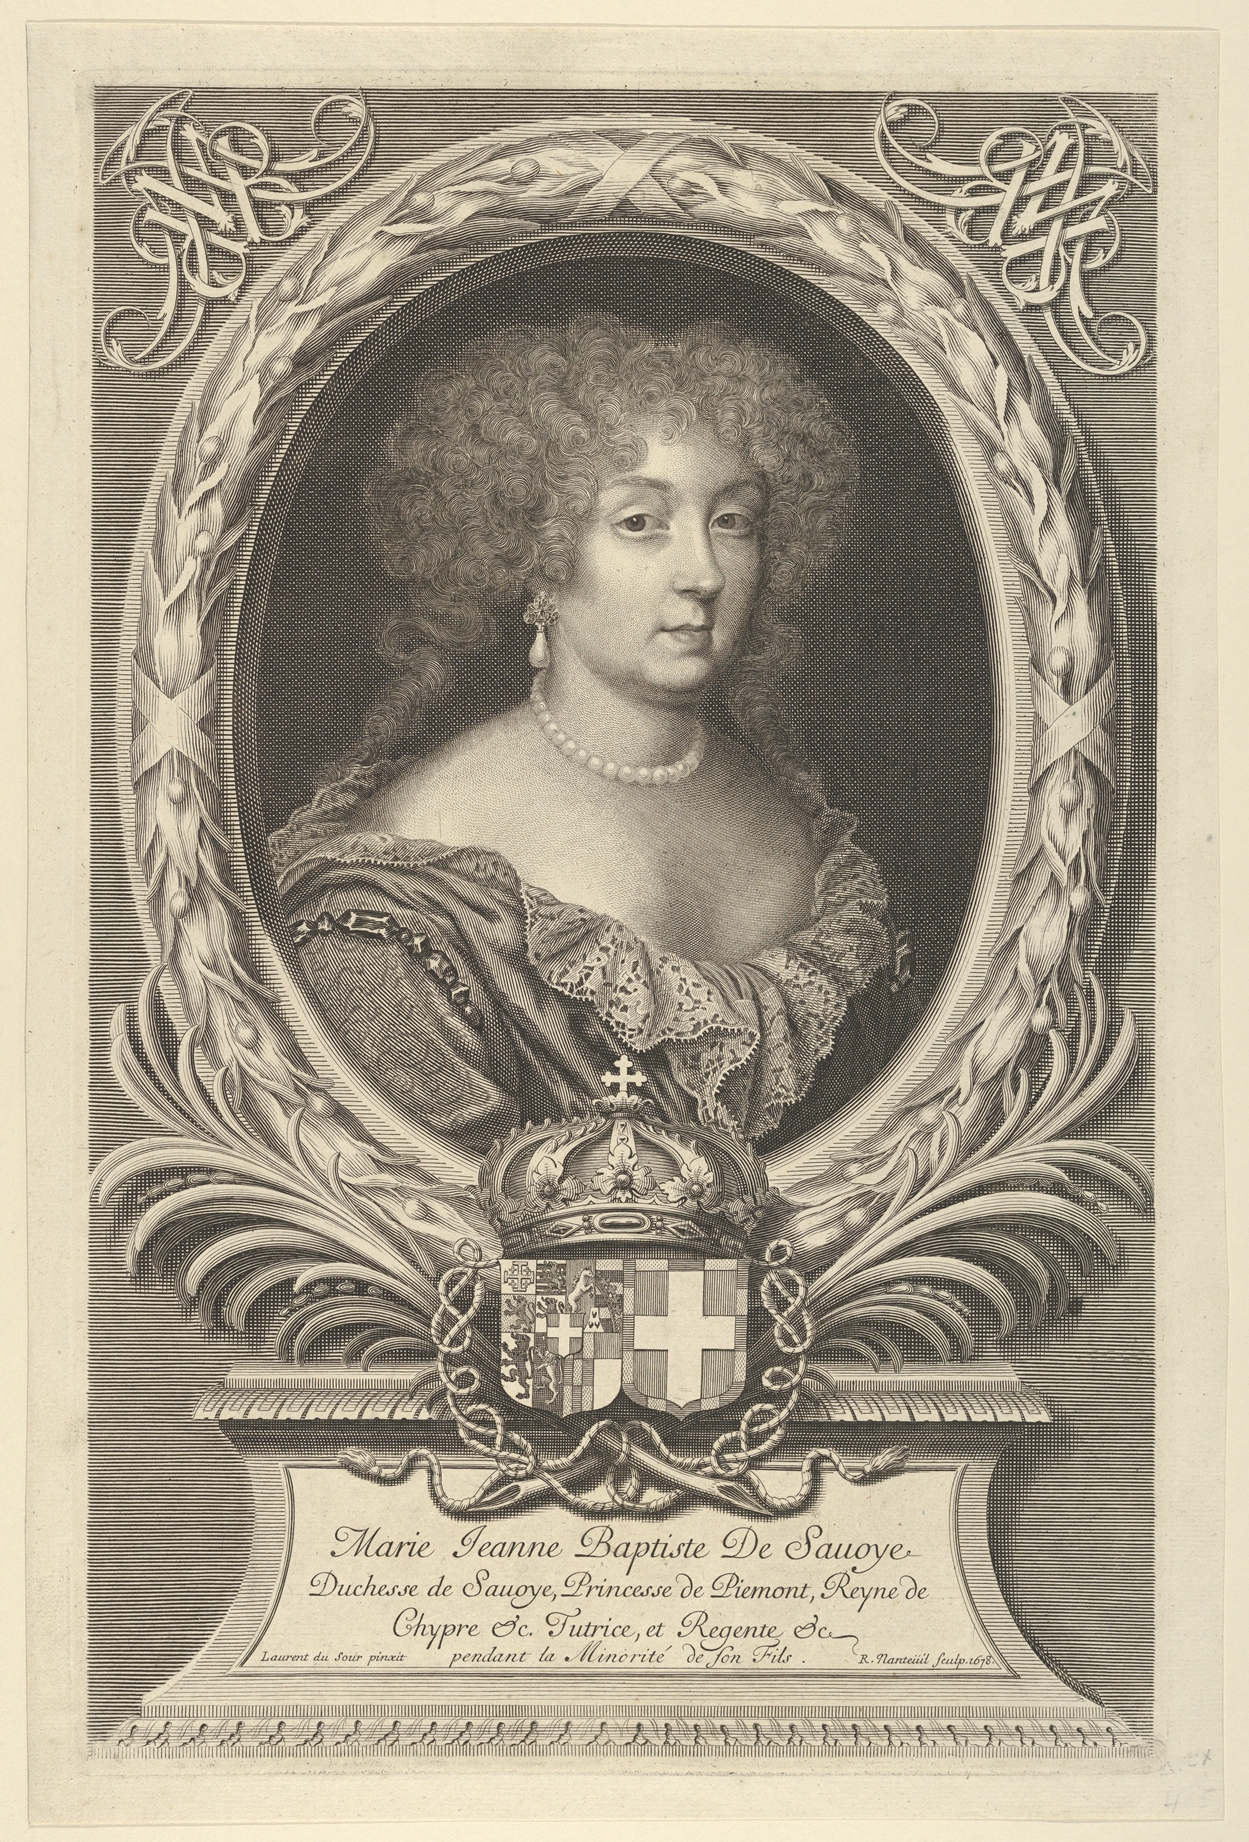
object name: print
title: Marie Jeanne Baptiste de Savoie-Nemours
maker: robert nanteuil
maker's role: artist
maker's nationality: french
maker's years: 1623-1678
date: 1678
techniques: engraving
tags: portraits,women,coat of arms